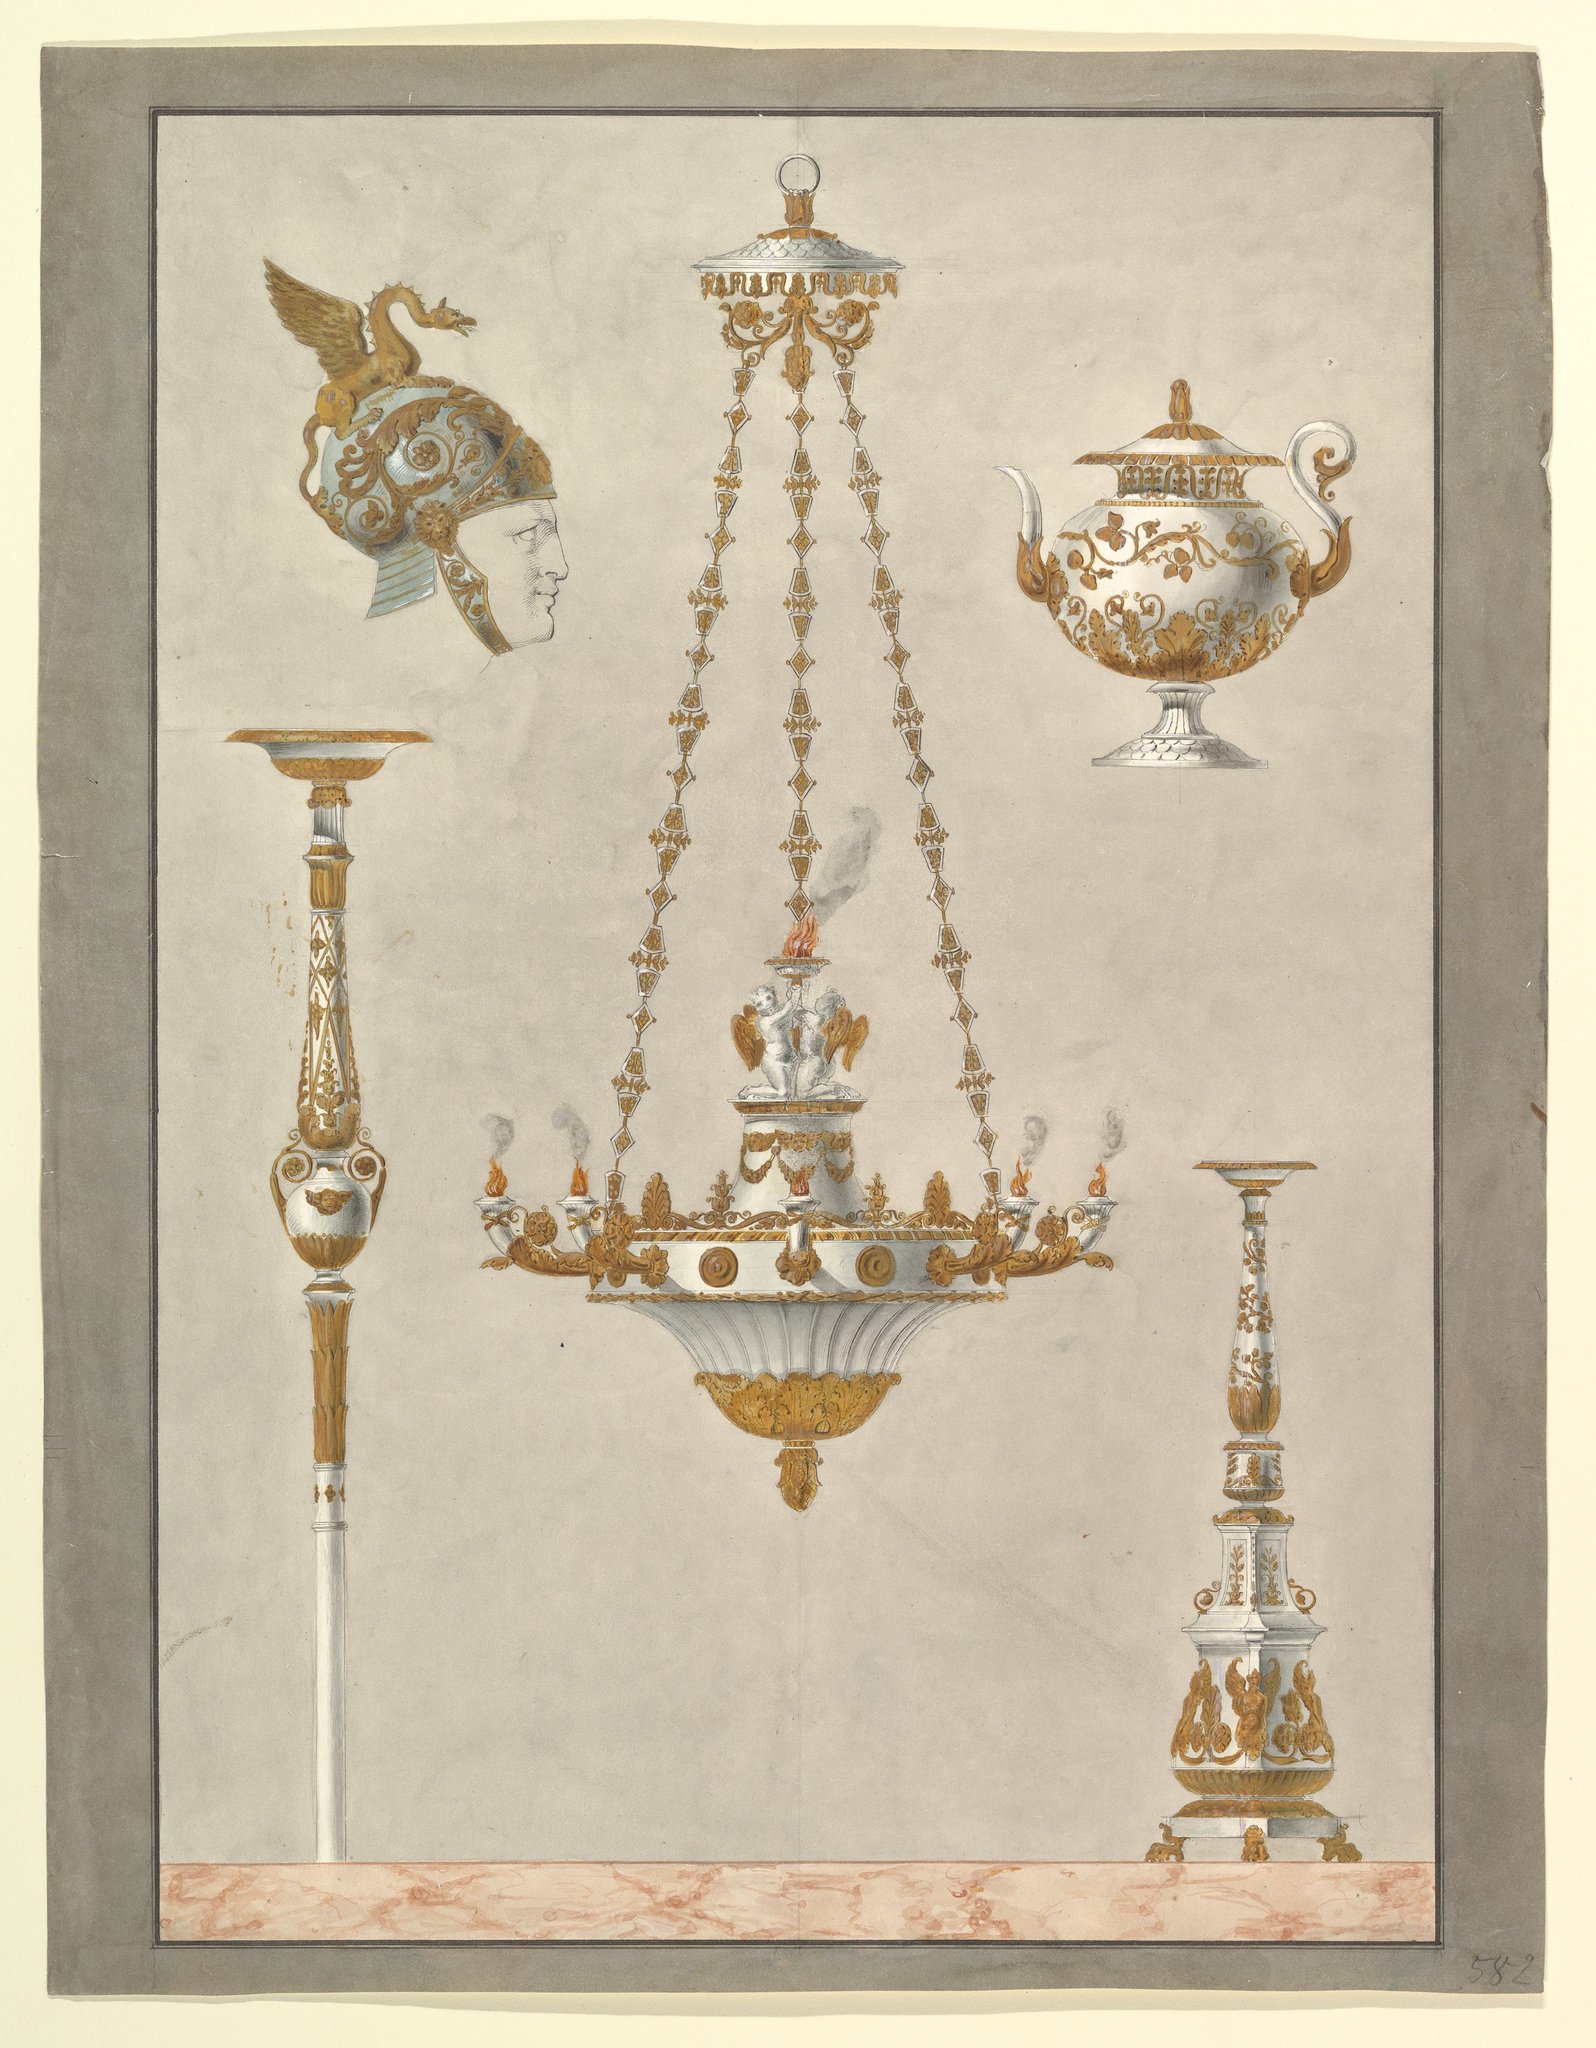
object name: drawing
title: Designs for Metalwork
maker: anonymous, italian, 19th century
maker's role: artist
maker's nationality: italian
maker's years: 1800-1900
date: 1801-1900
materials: chalk, ink, watercolor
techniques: brush, heightening, pen